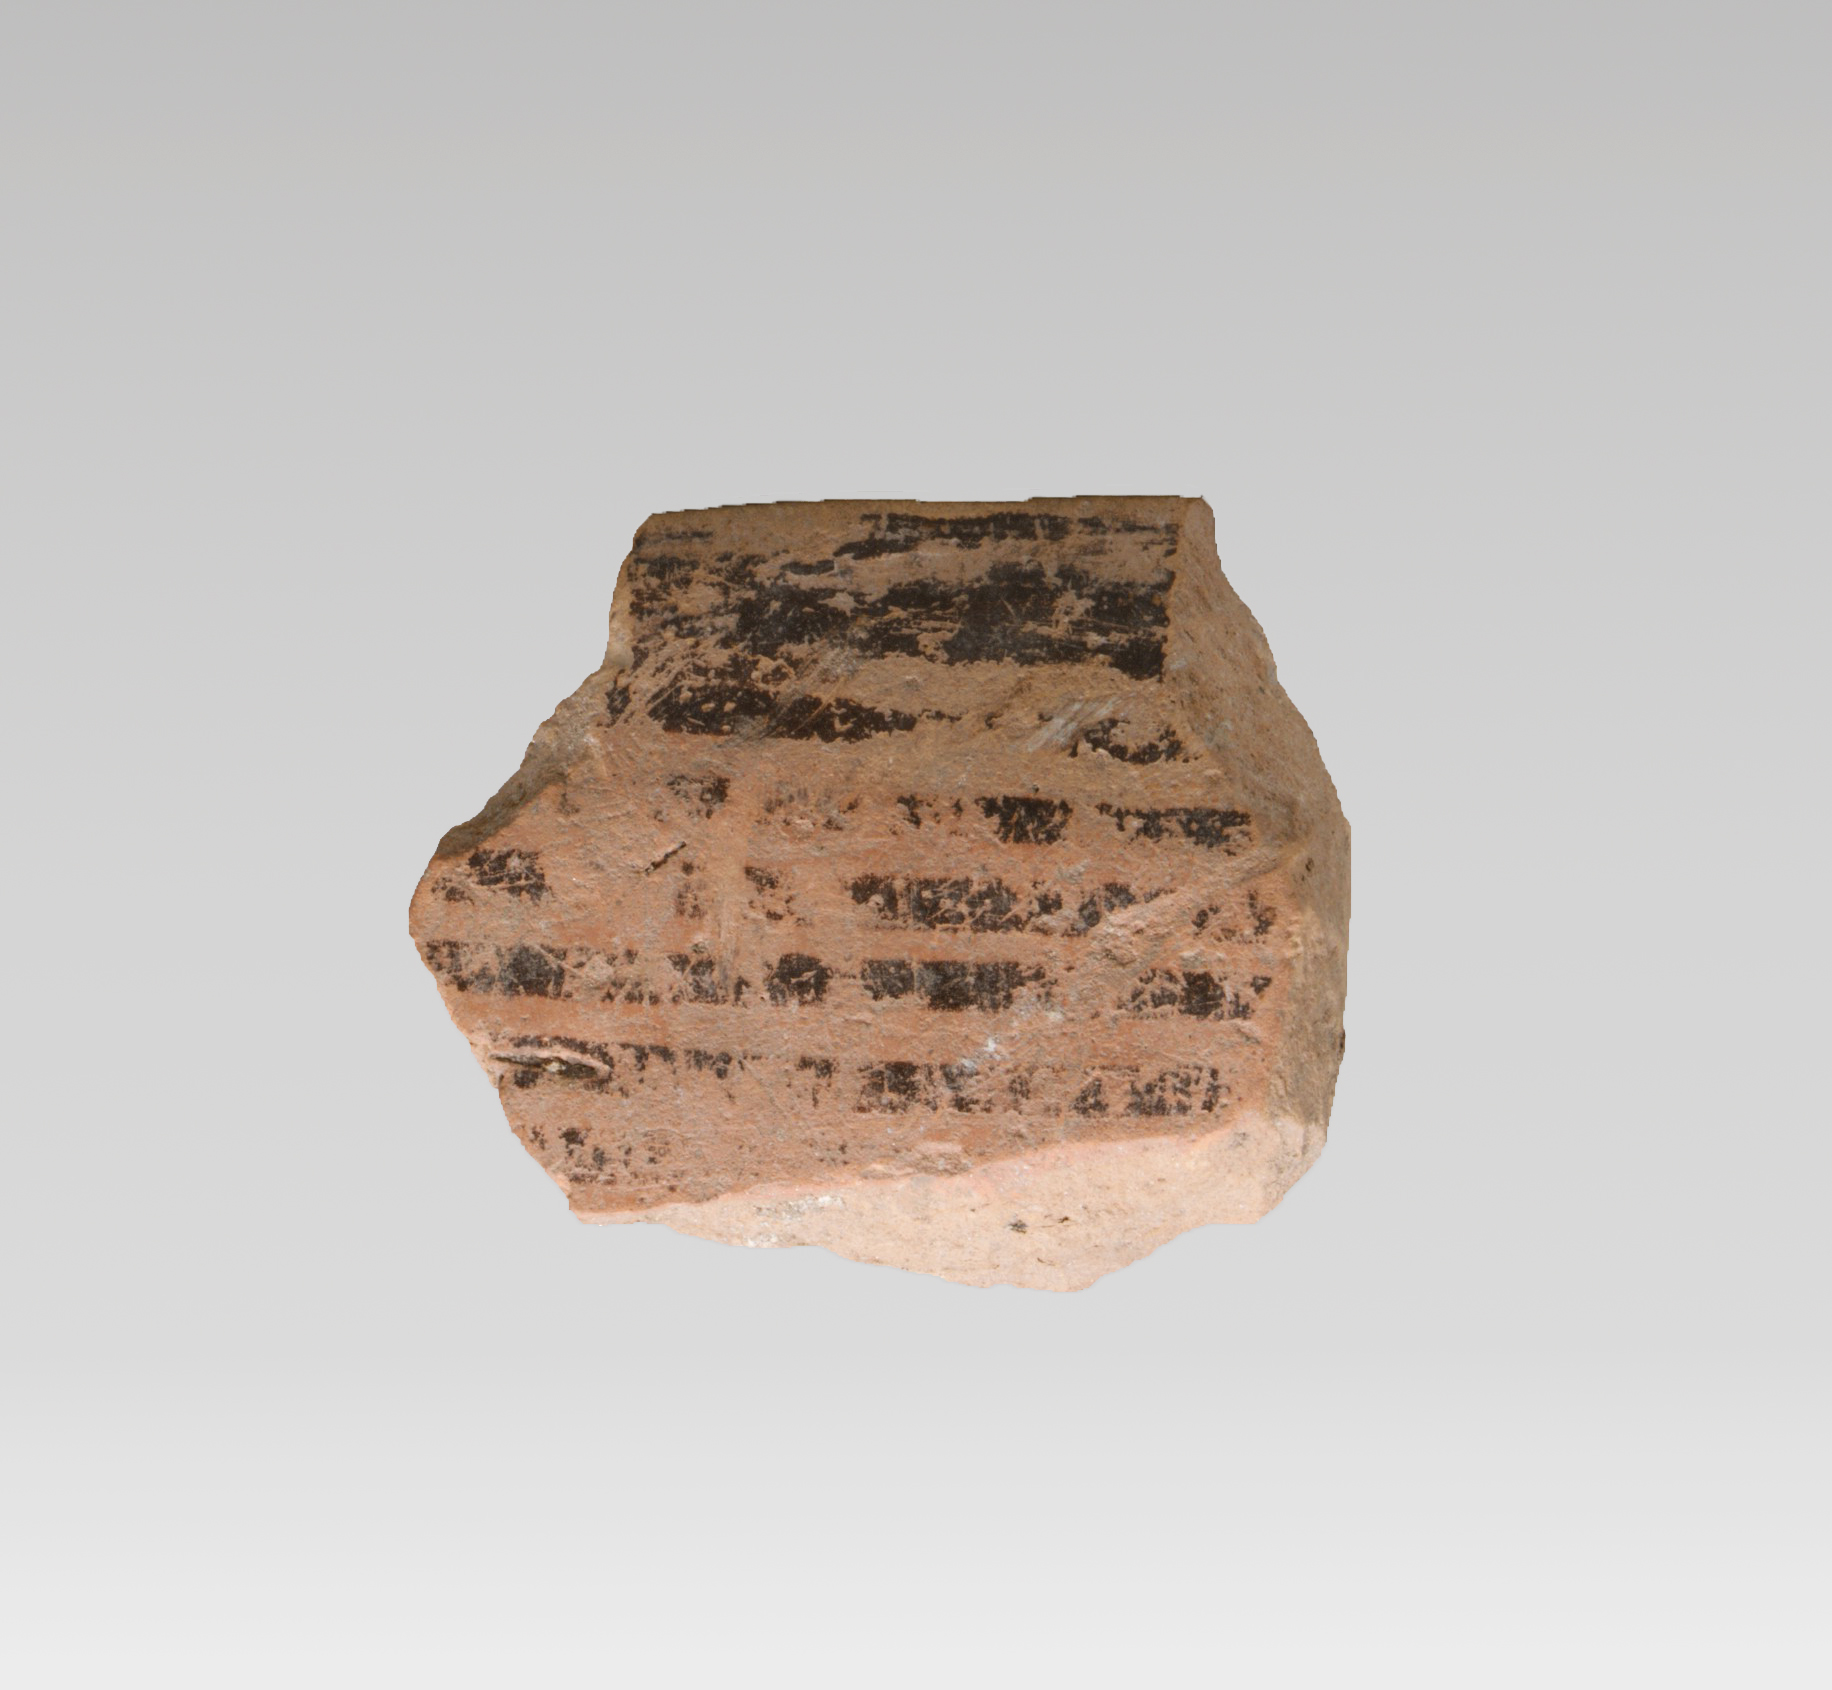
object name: vase fragment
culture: neolithic, thessaly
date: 4000-3000 BCE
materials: terracotta